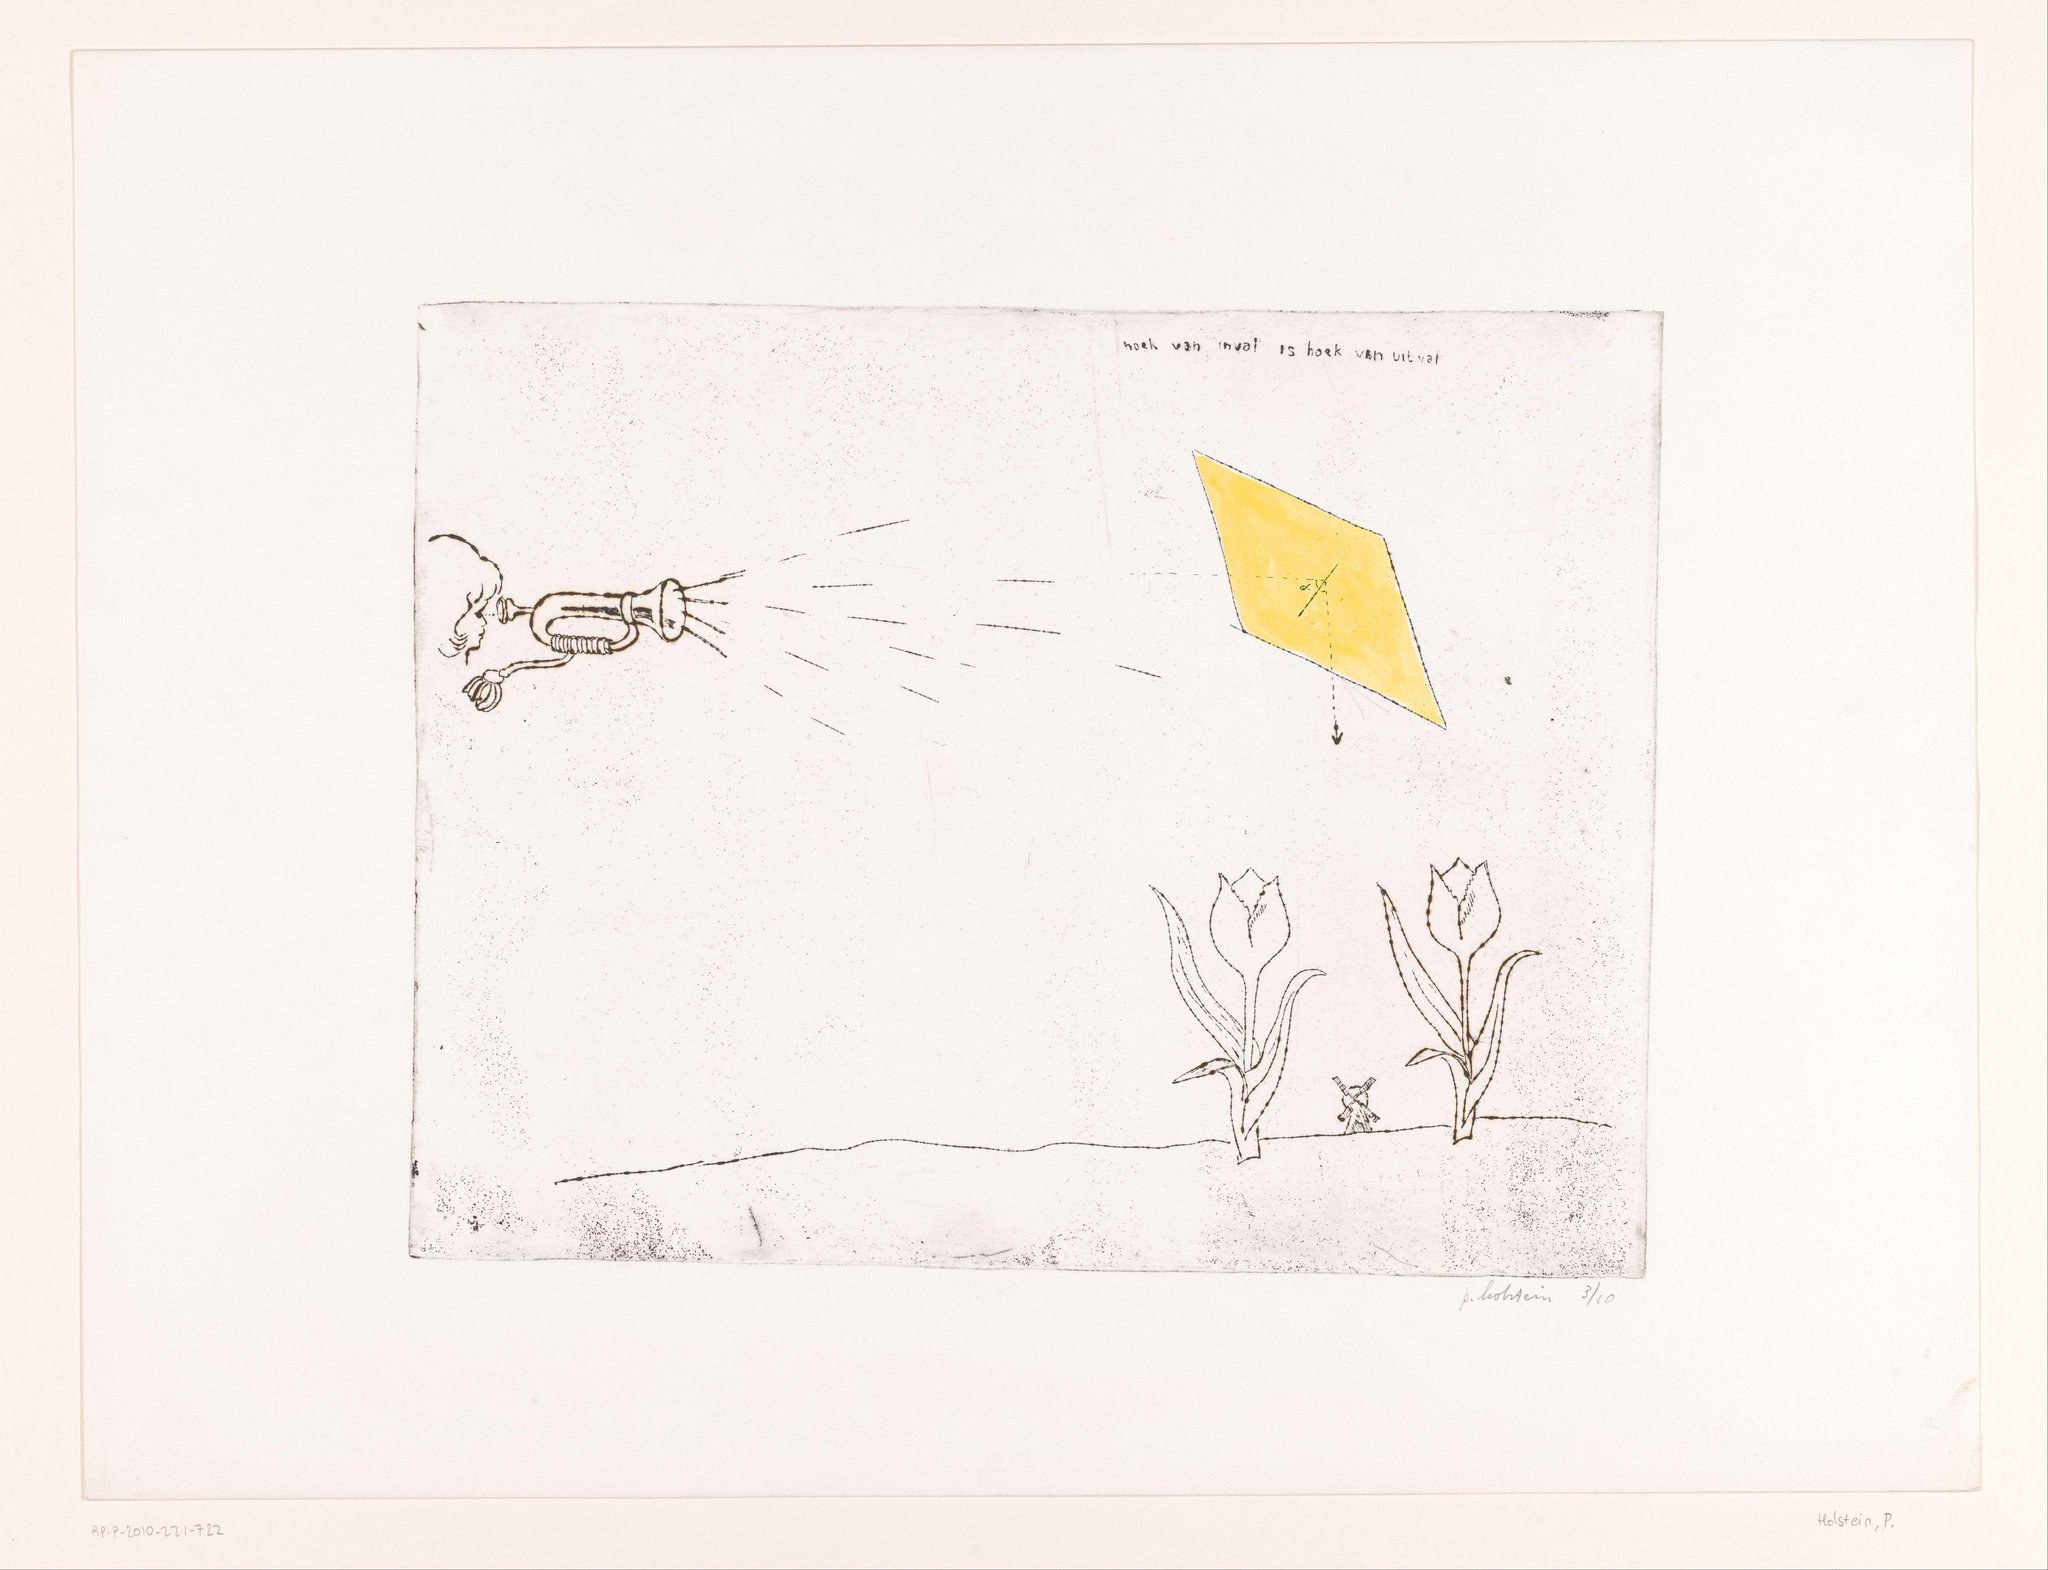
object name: print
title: Hoek van inval is hoek van uitval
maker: pieter holstein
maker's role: draughtsman, painter, print maker, sculptor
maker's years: 1934-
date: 1960-1967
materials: paper, watercolor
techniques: brush, etching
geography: amsterdam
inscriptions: signature: ‘p. holstein’, title: ‘hoek van inval is hoek van uitval’, edition: ‘3/10’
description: Trompet en geel parallellogram, rechtsonder tulpen en een molen. Het geluid van de trompet bereikt de tulpen via de geometrische zwevende figuur.